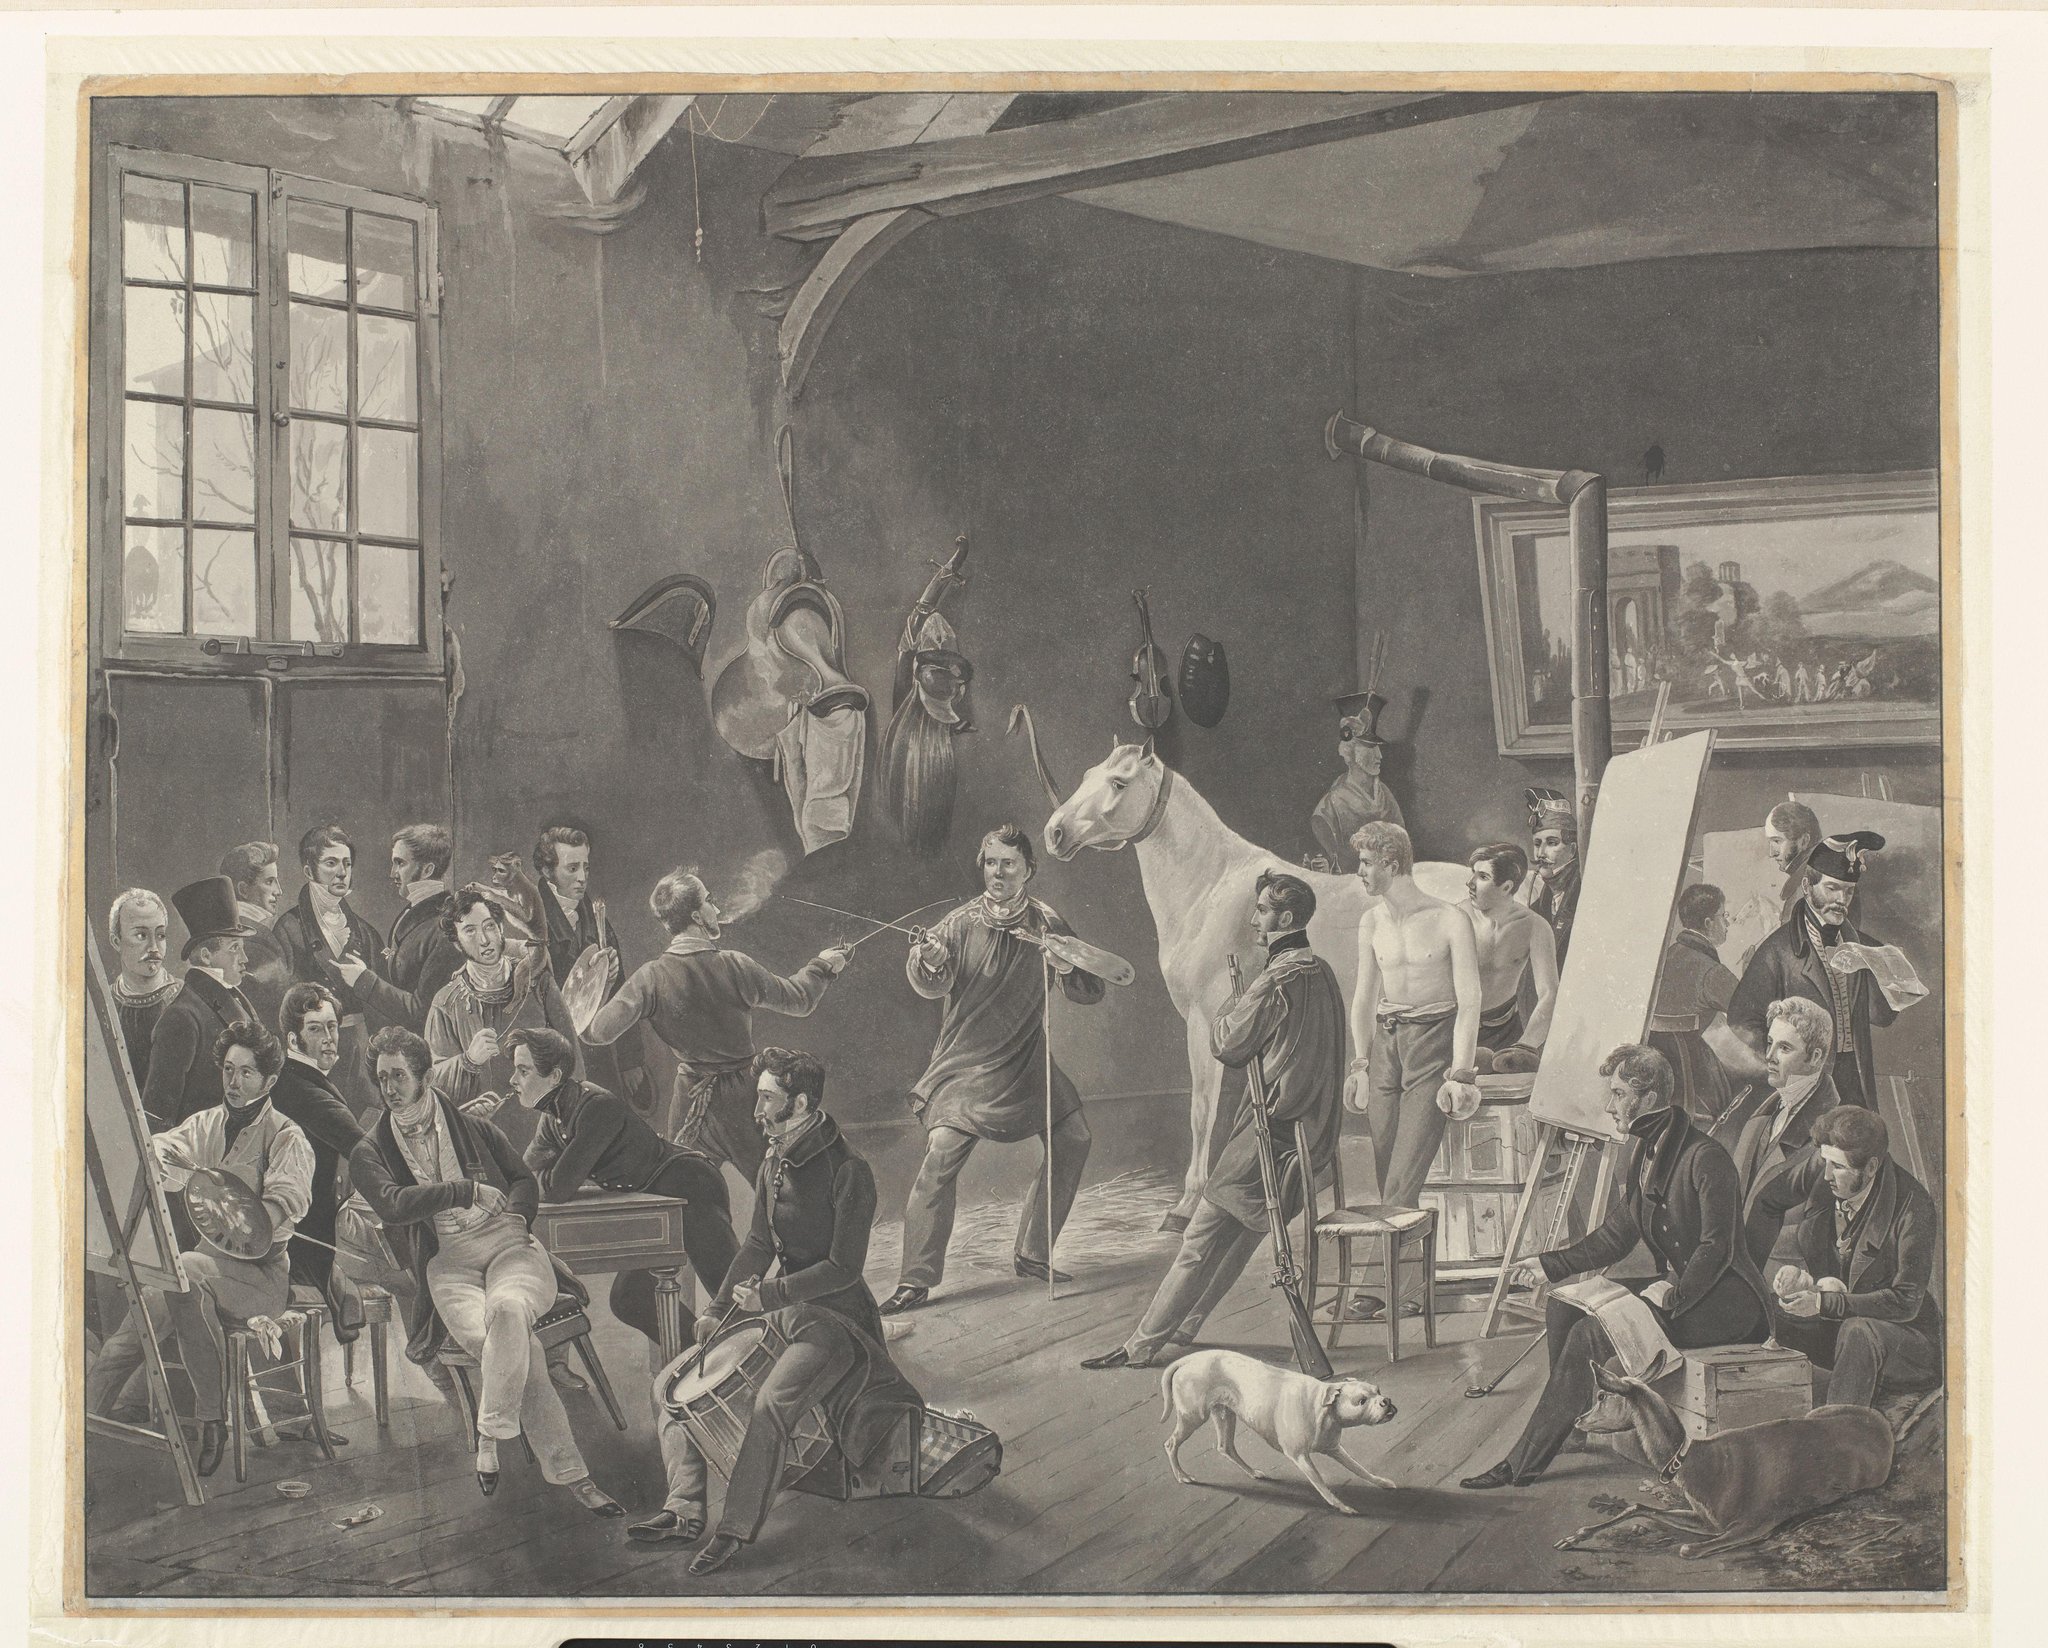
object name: drawing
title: Duel tussen twee schilders in een sociëteit met veel omstanders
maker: Anonymous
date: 1800-1900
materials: ink, paper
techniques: brush, pen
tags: hacking and thrusting weapons, painter at work, in his studio, painter in non-work situation (+ circle, club of artists), duelling